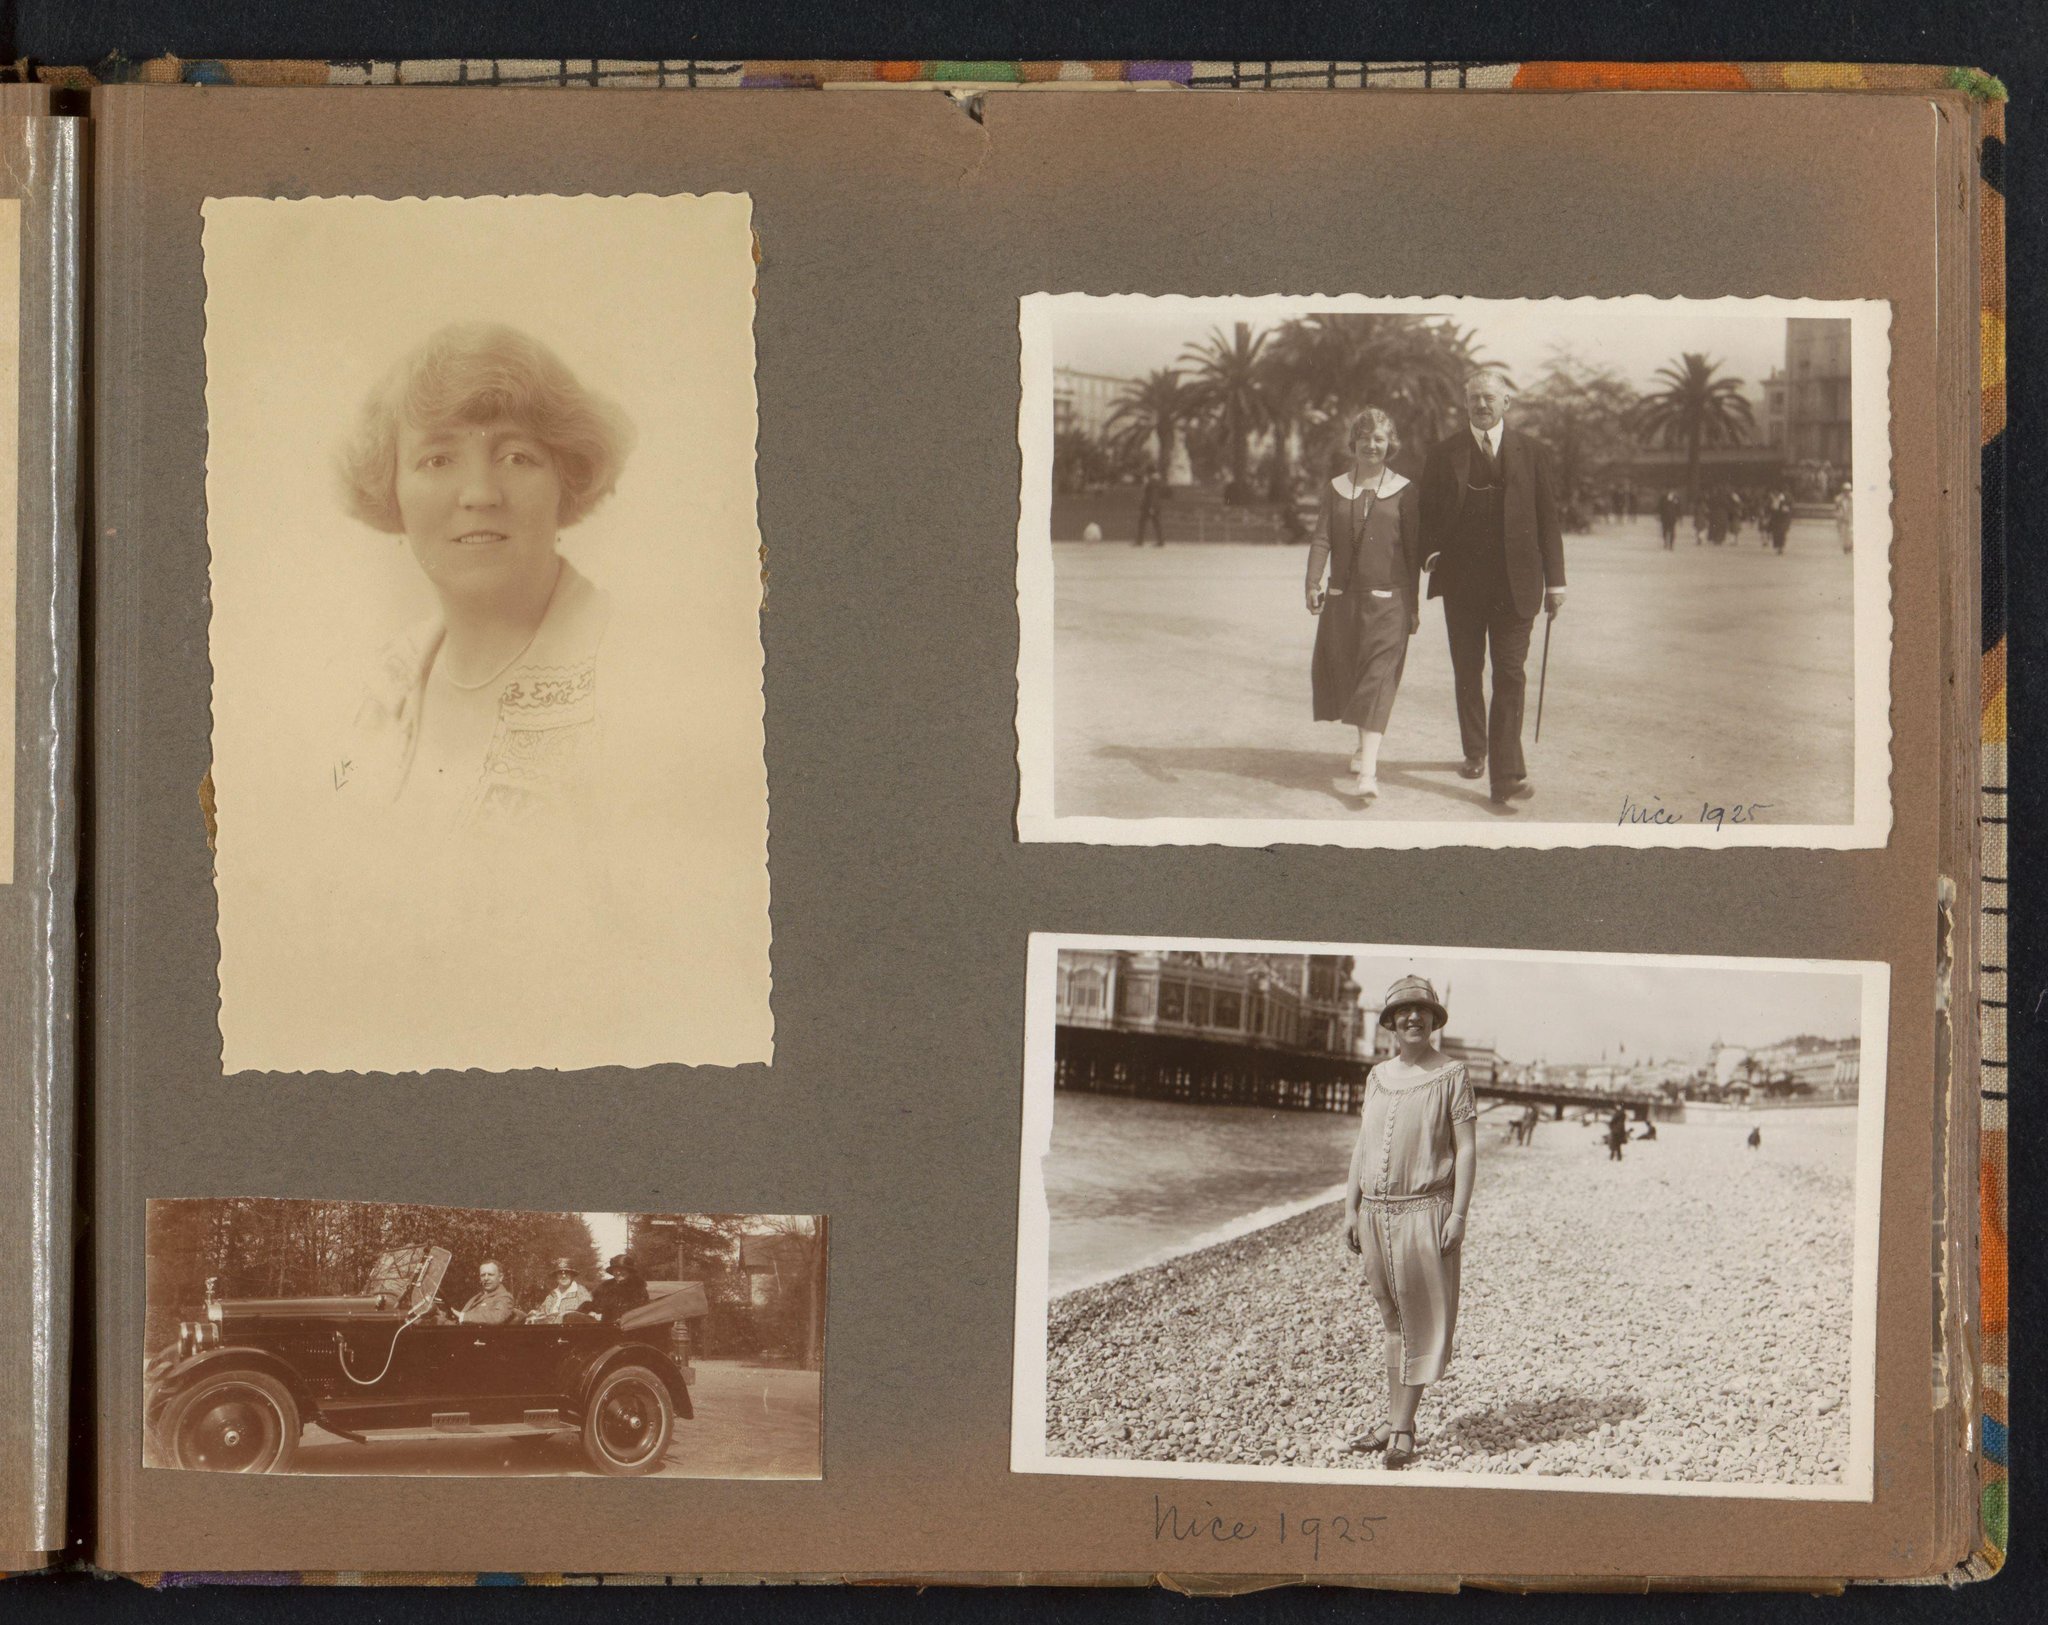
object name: album leaf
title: Vakantie en portret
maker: Anonymous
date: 1900-1925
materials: cardboard, photographic support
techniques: gelatin silver print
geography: nice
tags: beach (as place of recreation), adult woman, adult man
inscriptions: signature: ‘L.K.’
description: Albumblad met foto's van een jonge vrouw en van een drietal in een auto. Ook een foto van een stel wandelend in Nice en van een vrouw aan het strand aldaar. Onderdeel van Fotoalbum van een onbekende Nederlandse familie met connecties in Suriname en Nederlands-Indië (2).